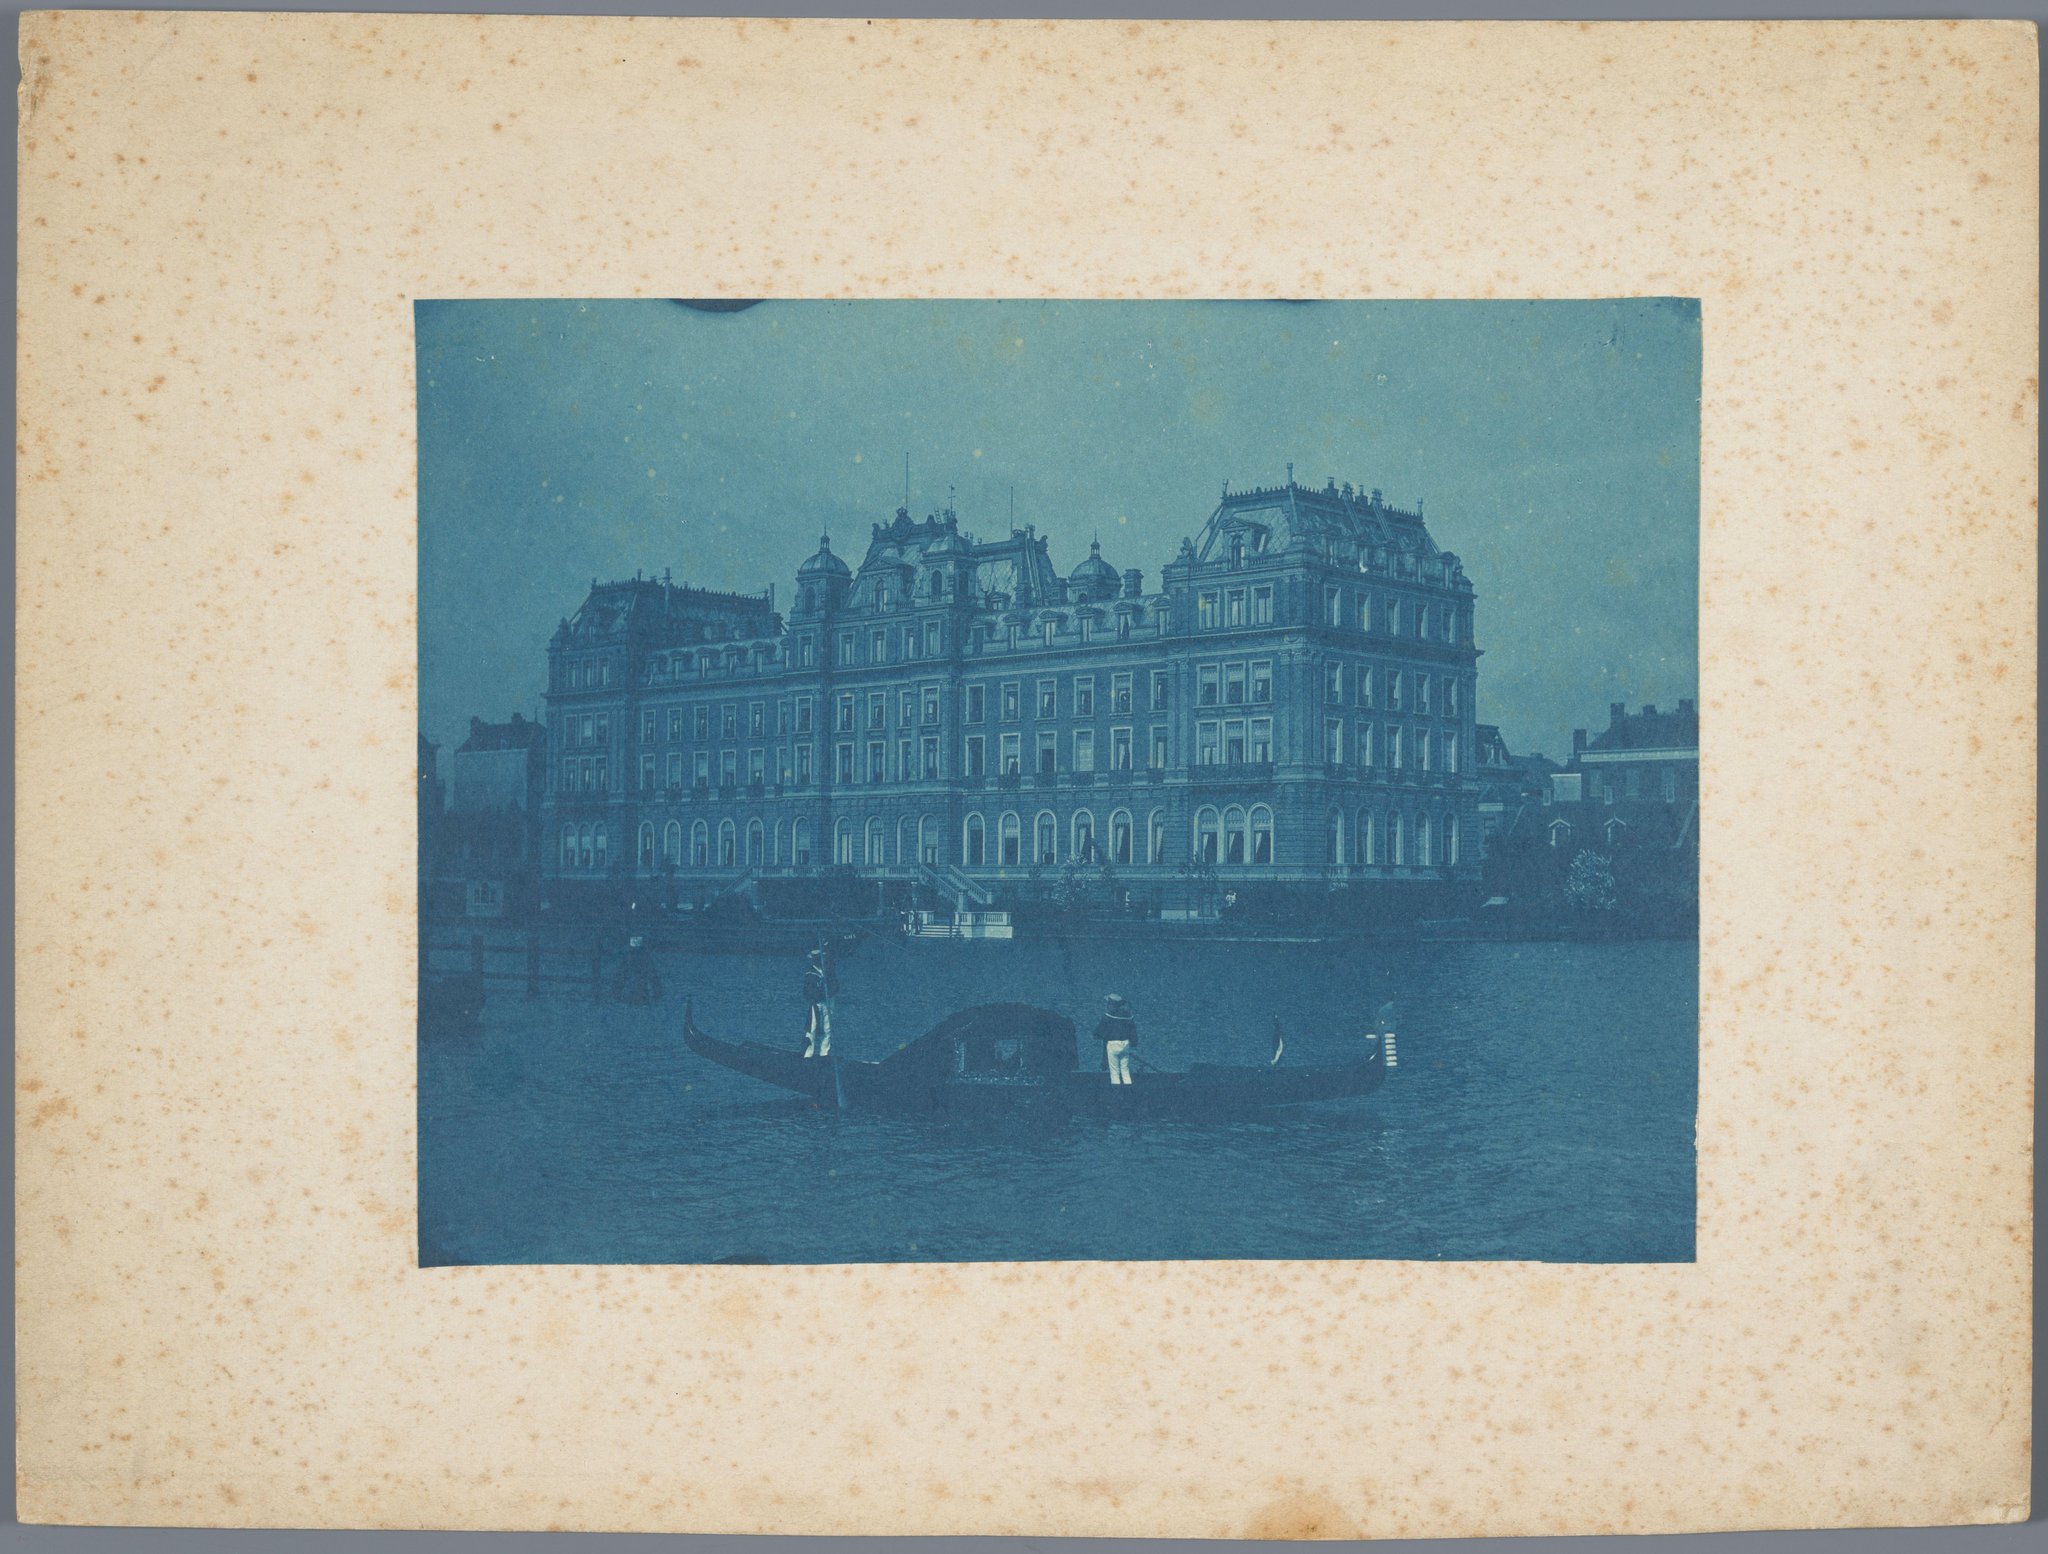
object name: photograph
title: Amstelhotel met gondel in de Amstel in Amsterdam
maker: Anonymous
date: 1870-1920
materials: cardboard, paper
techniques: cyanotype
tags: canals, waters (in city), gondola, hotel, hostelry, inn